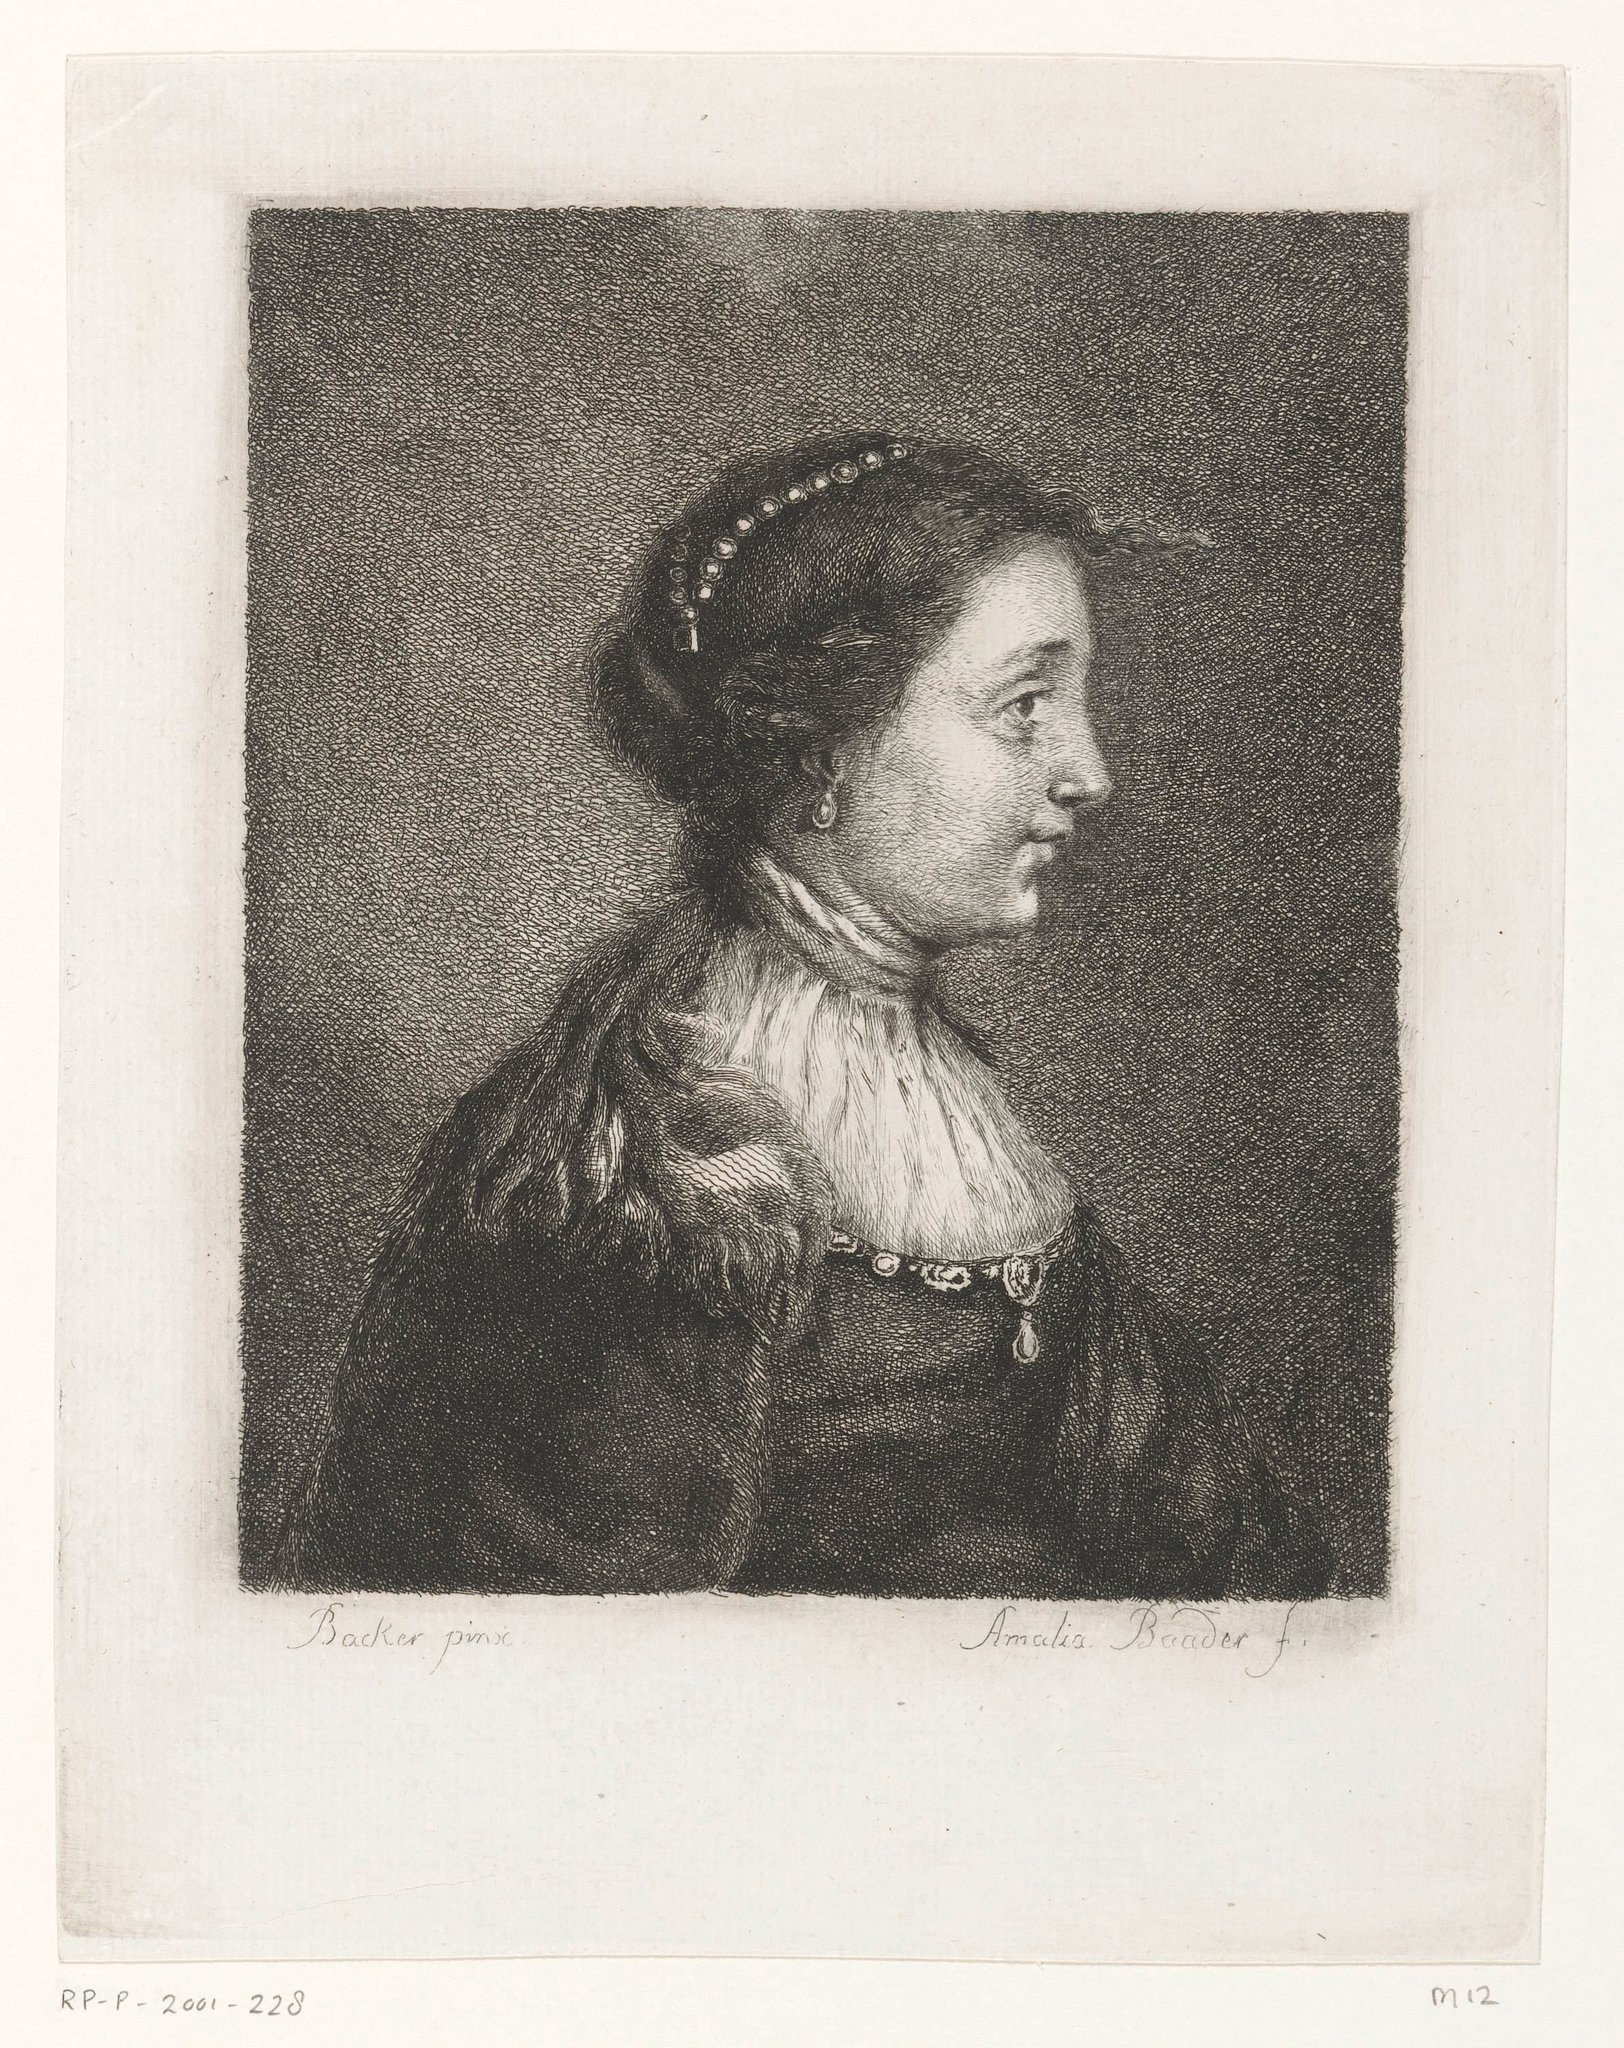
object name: print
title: Borstbeeld van een vrouw met parels in het haar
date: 1773-1840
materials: paper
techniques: etching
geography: netherlands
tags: ornaments, jewels, anonymous historical person portrayed - bb - woman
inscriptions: collector's mark: Lugt 2760, collector's mark: Lugt 2228